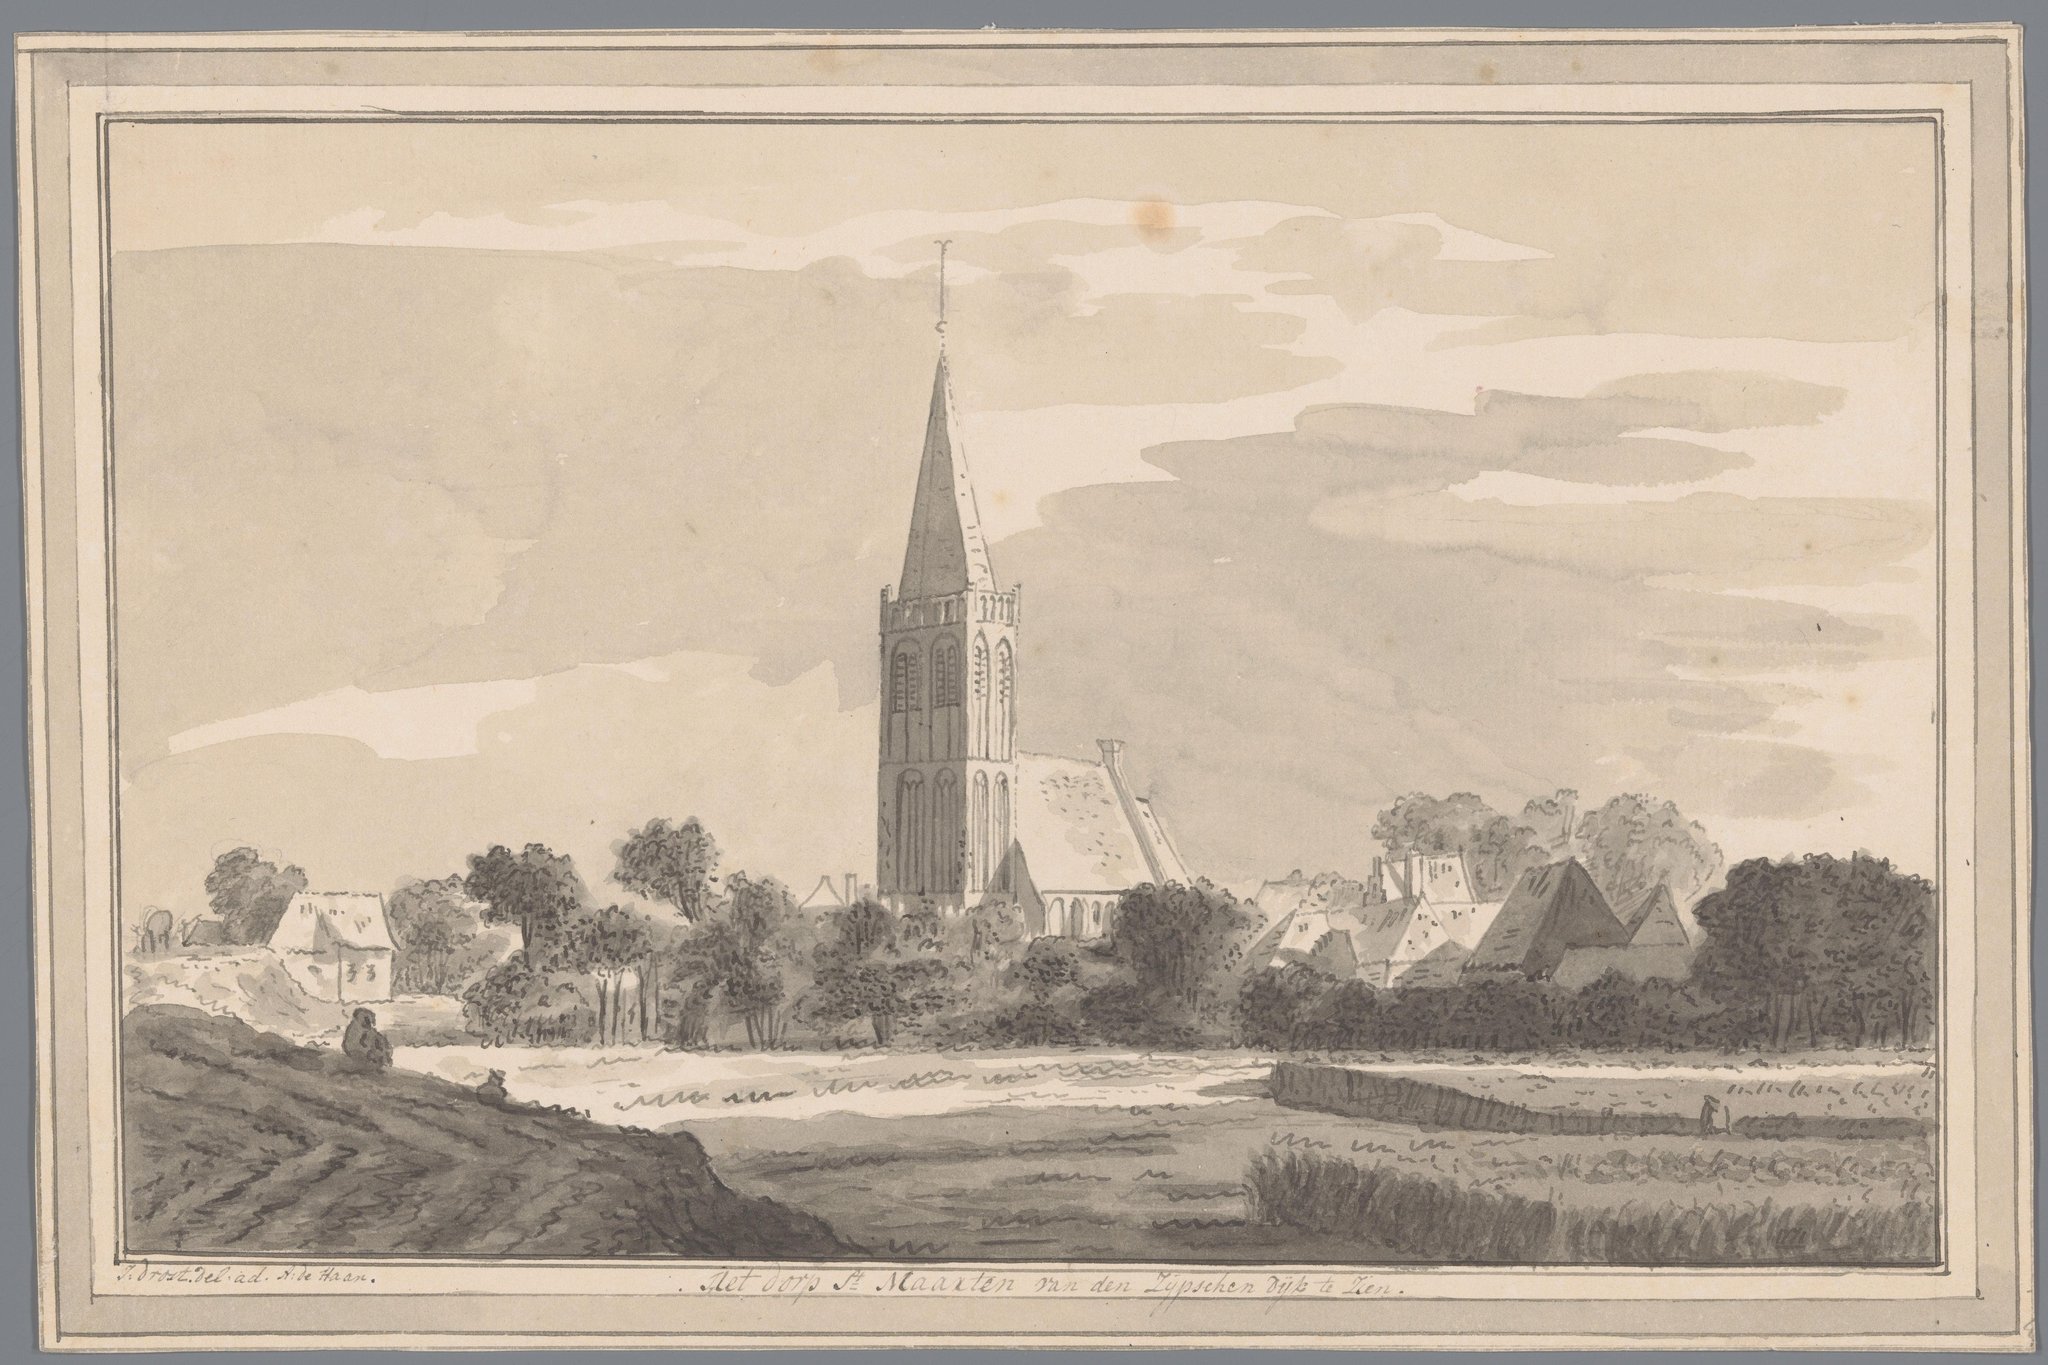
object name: drawing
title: Gezicht op Sint-Maarten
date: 1750-1850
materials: ink, paper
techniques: brush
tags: prospect of village, silhouette of village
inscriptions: collector's mark: Lugt 2228